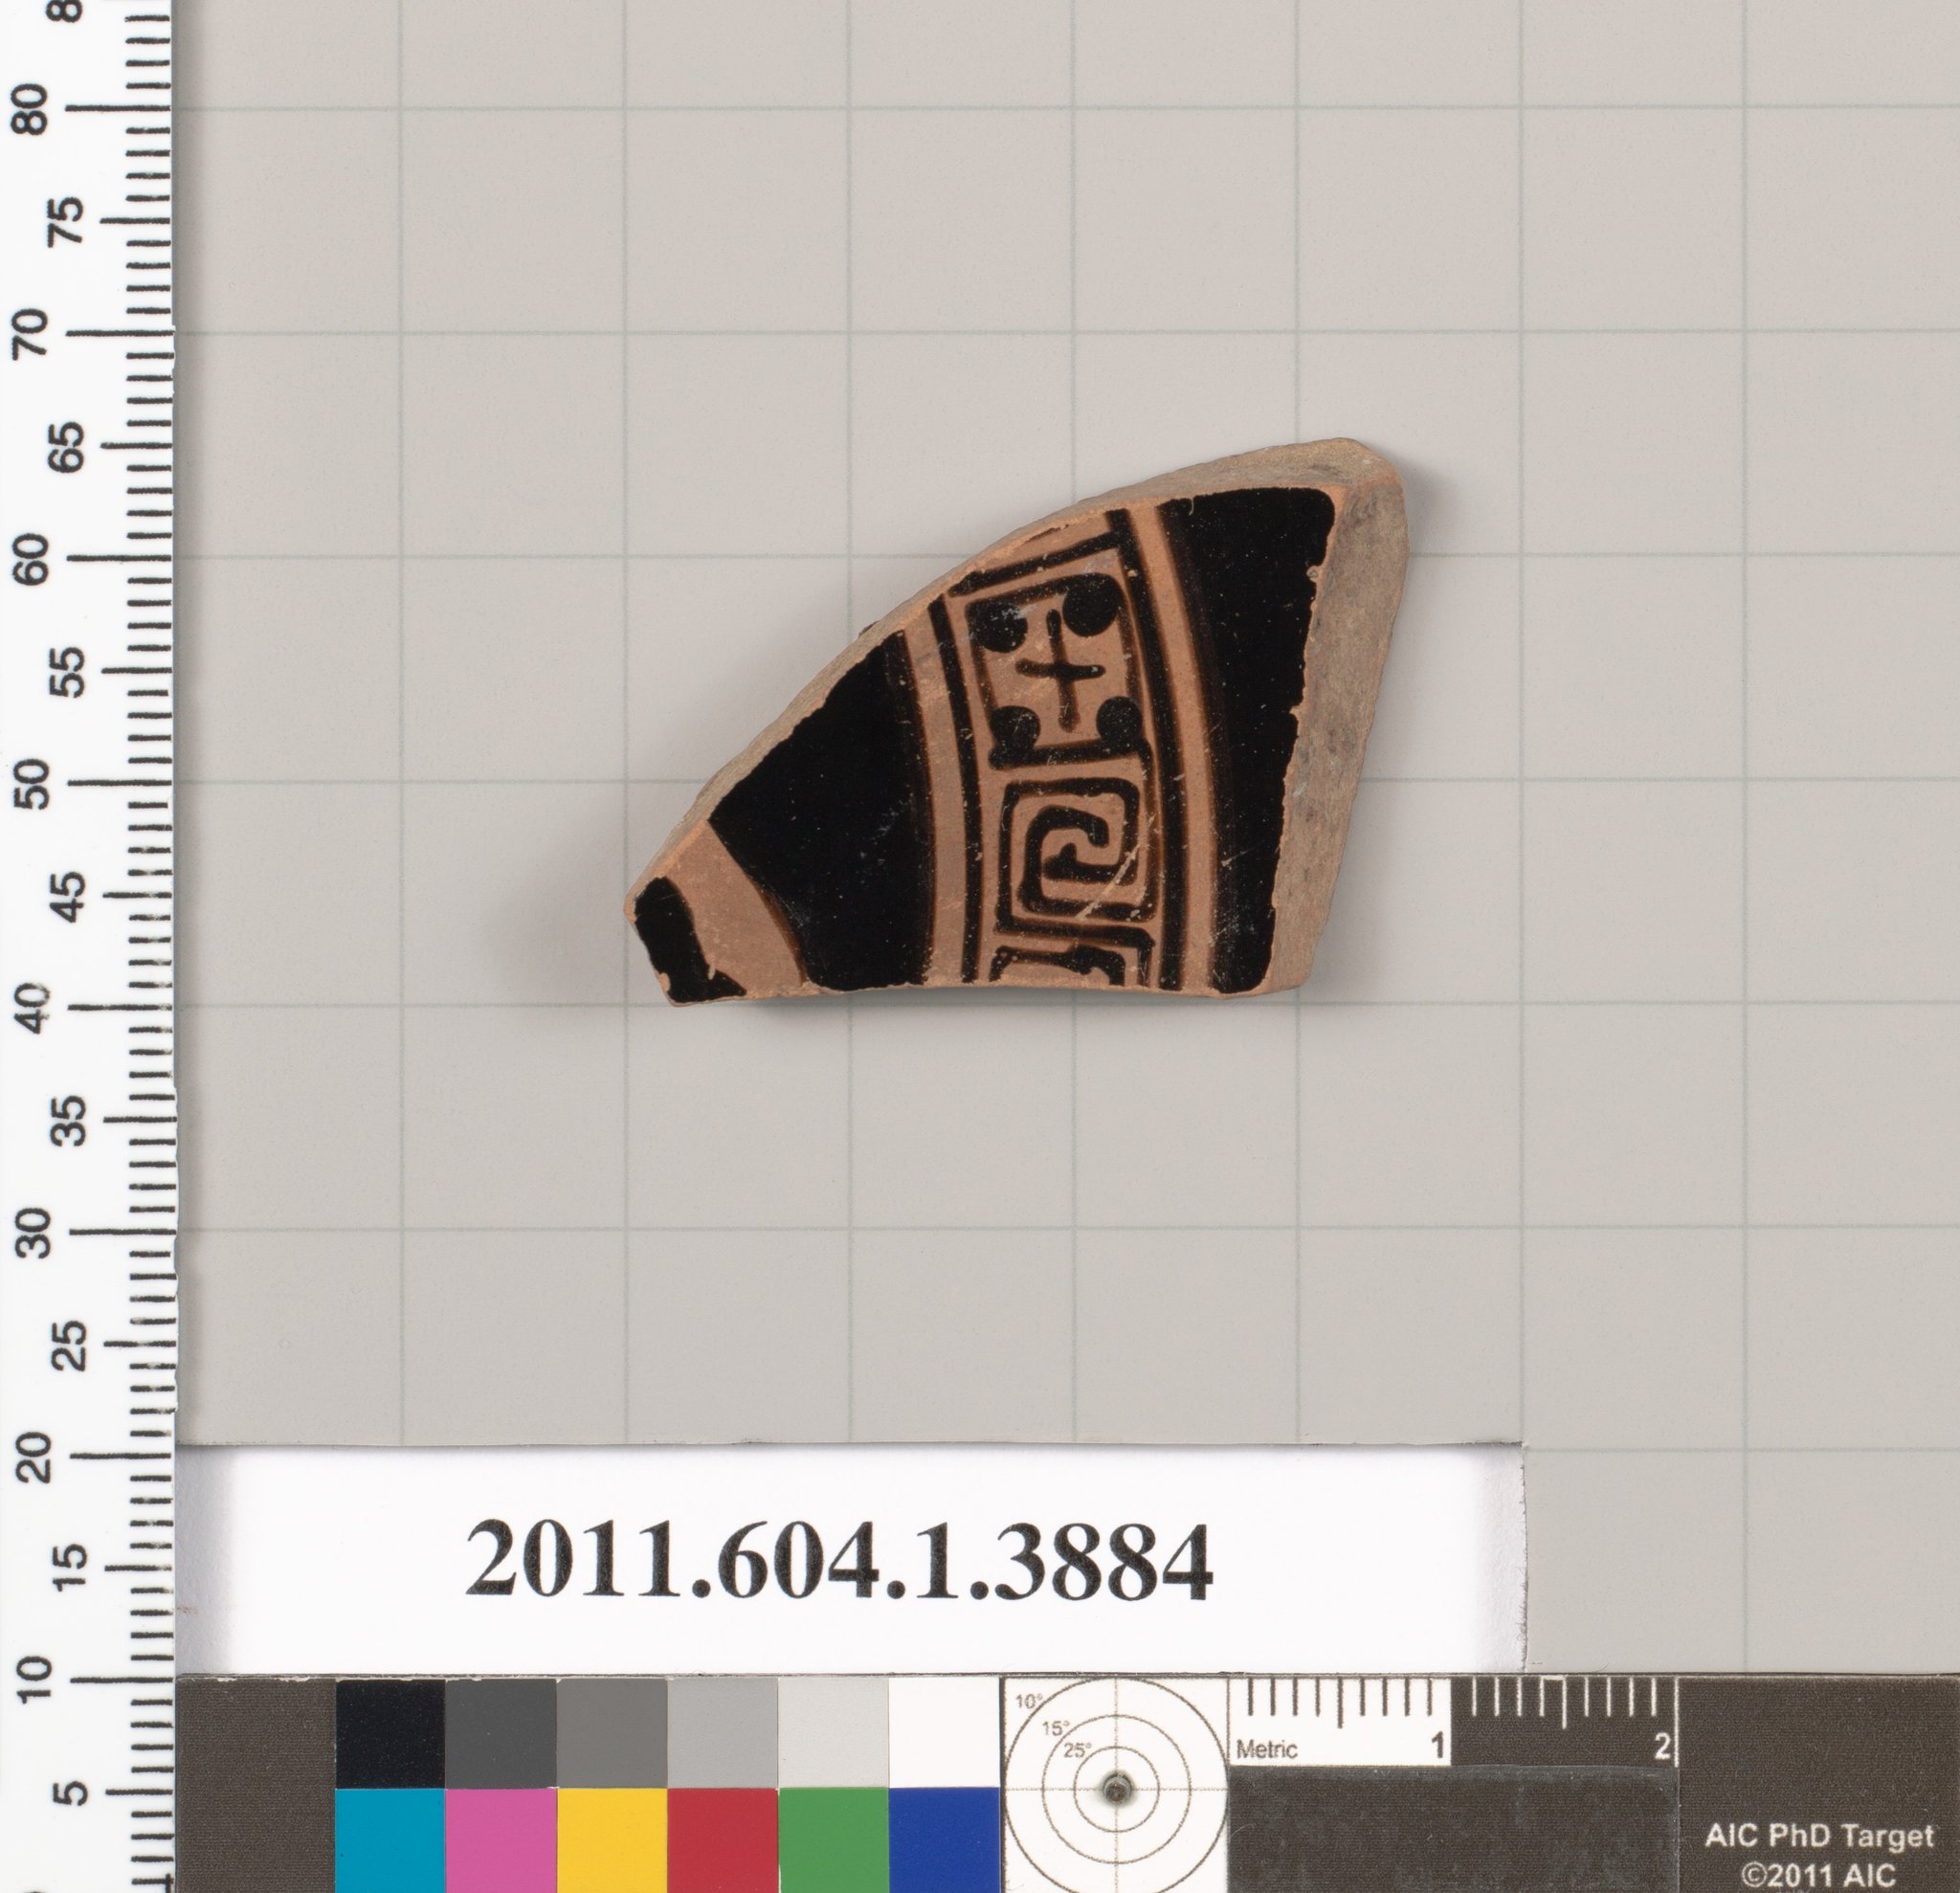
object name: kylix fragment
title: Terracotta fragment of a kylix (drinking cup)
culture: greek, attic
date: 460-440 BCE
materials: terracotta